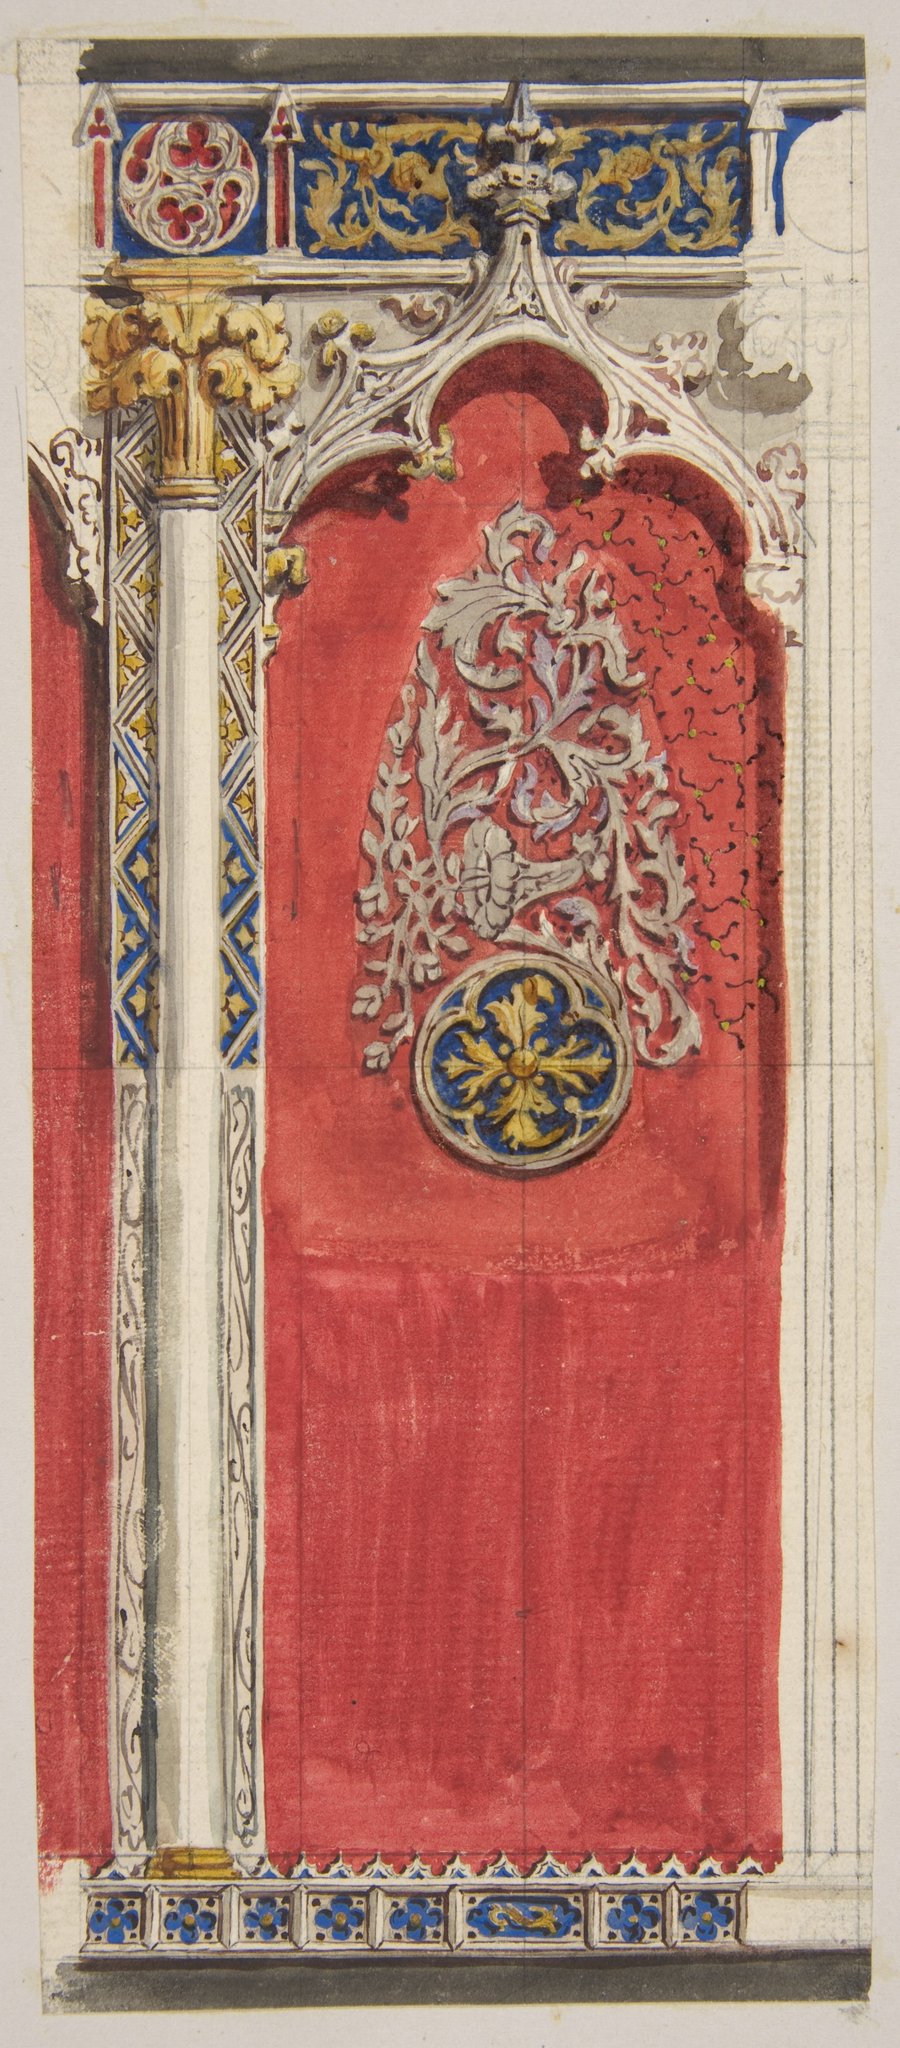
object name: drawing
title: Design for the decoration of a gothic niche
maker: jules-edmond-charles lachaise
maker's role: artist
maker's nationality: french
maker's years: 1897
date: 1851-1900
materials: cardboard, graphite, paper, watercolor